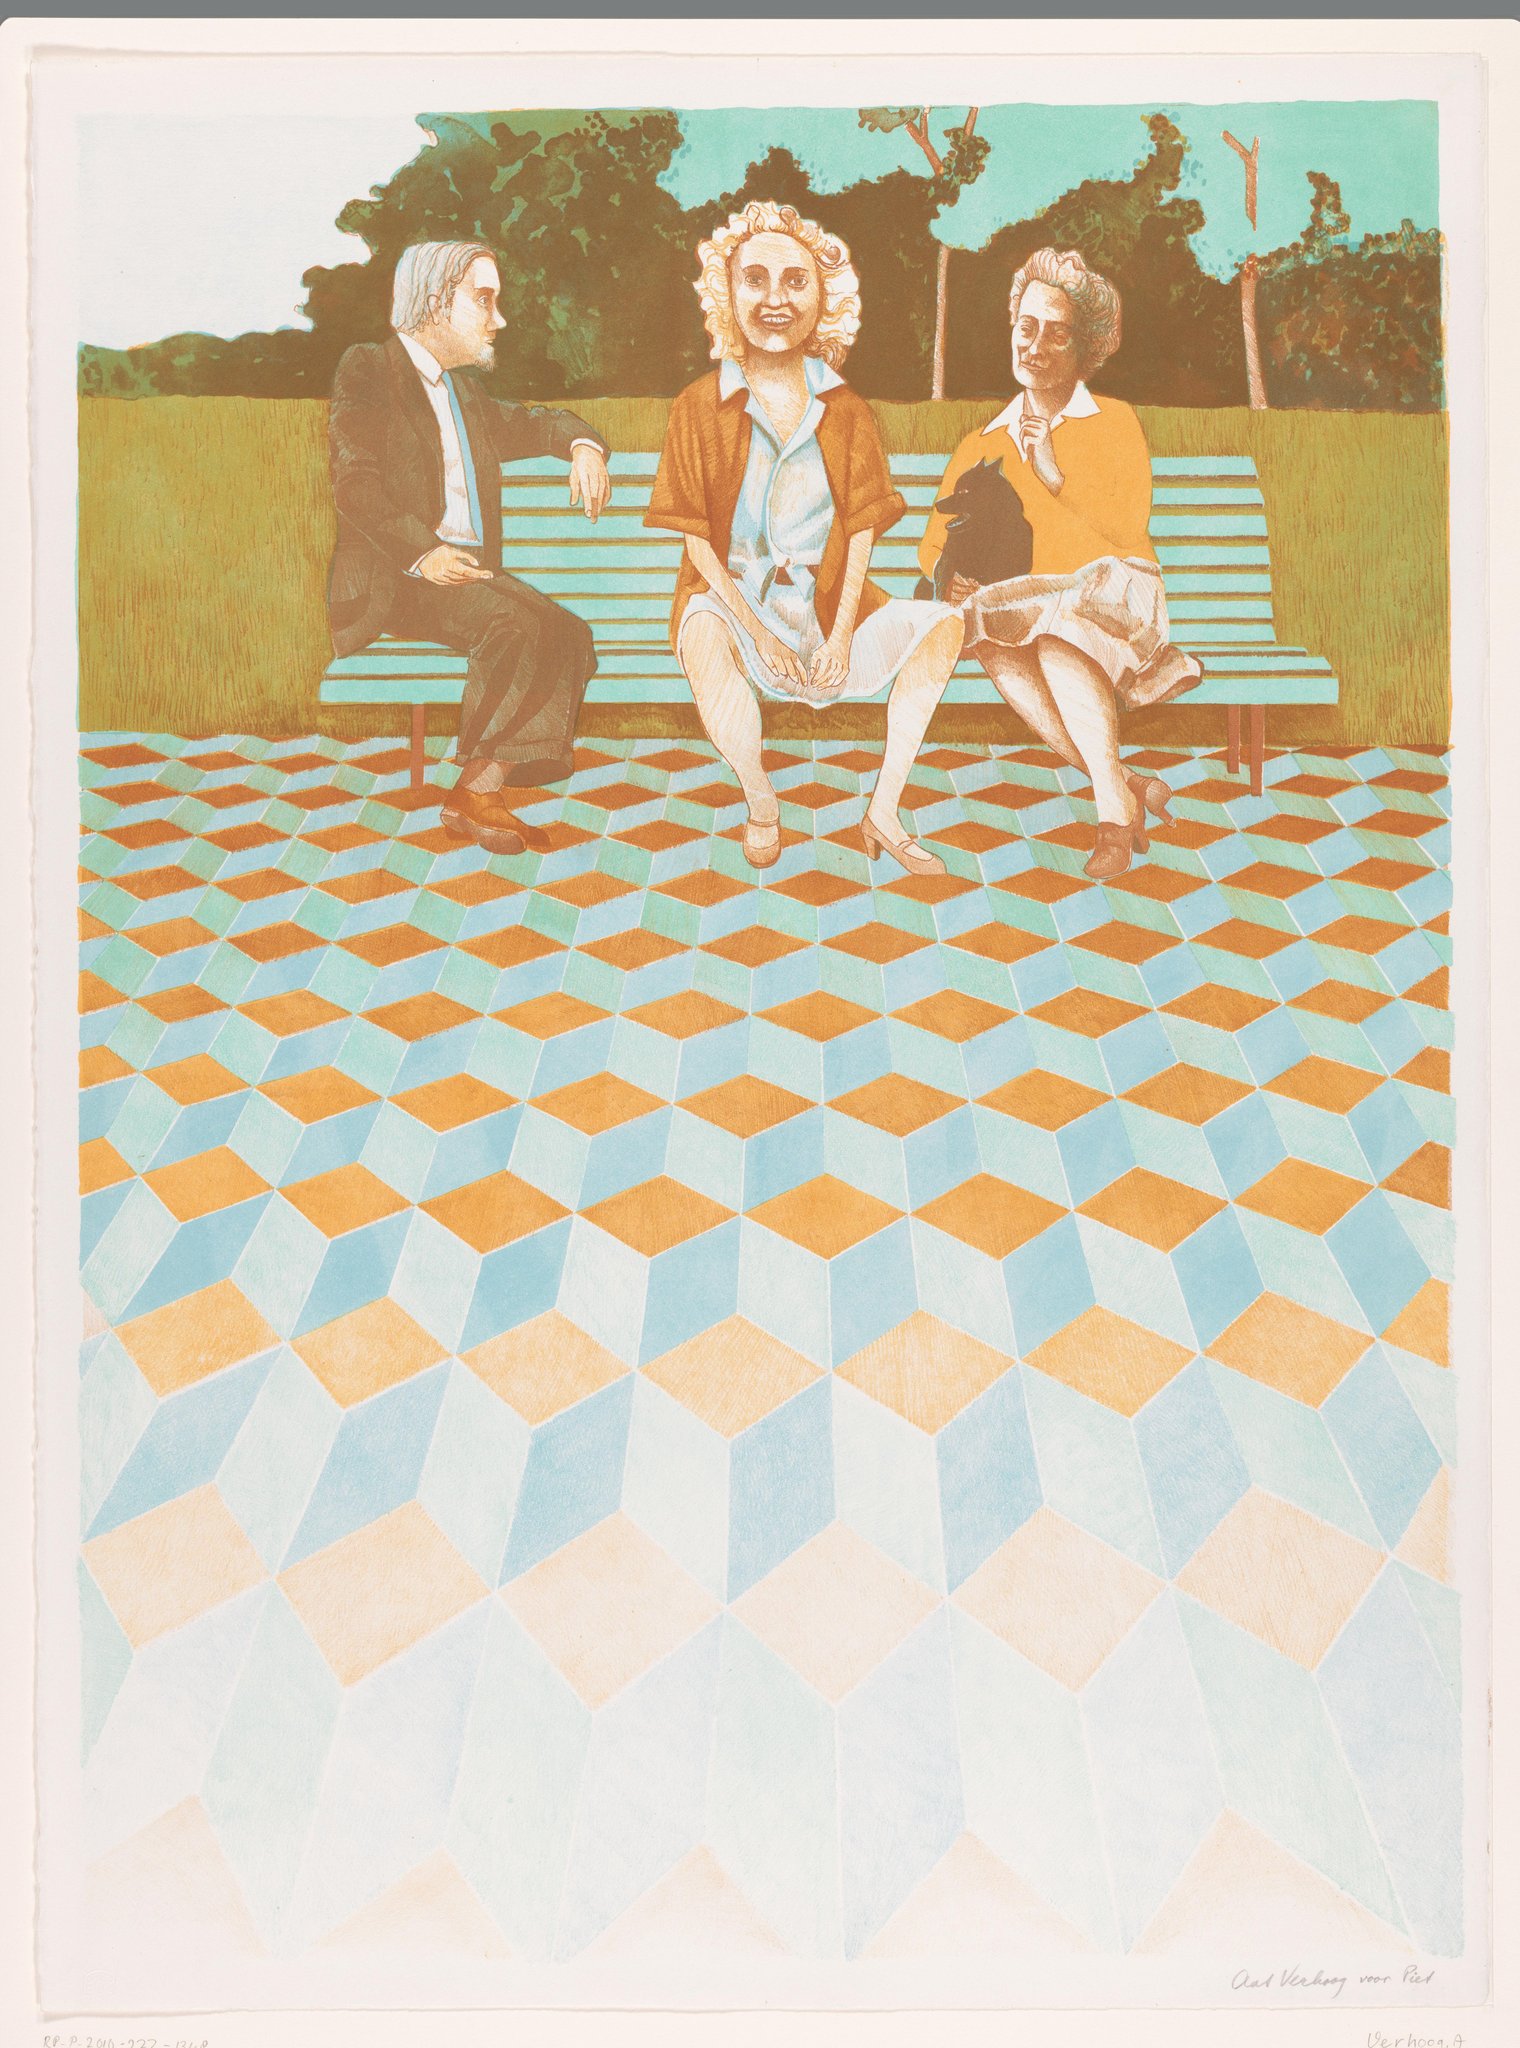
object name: print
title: Mensen op bankje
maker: aat verhoog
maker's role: print maker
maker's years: 1933-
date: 1965-1980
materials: paper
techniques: lithograph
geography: netherlands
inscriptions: signature: ‘Aat Verhoog’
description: Drie mensen op een bank op terras met kubusmotief.